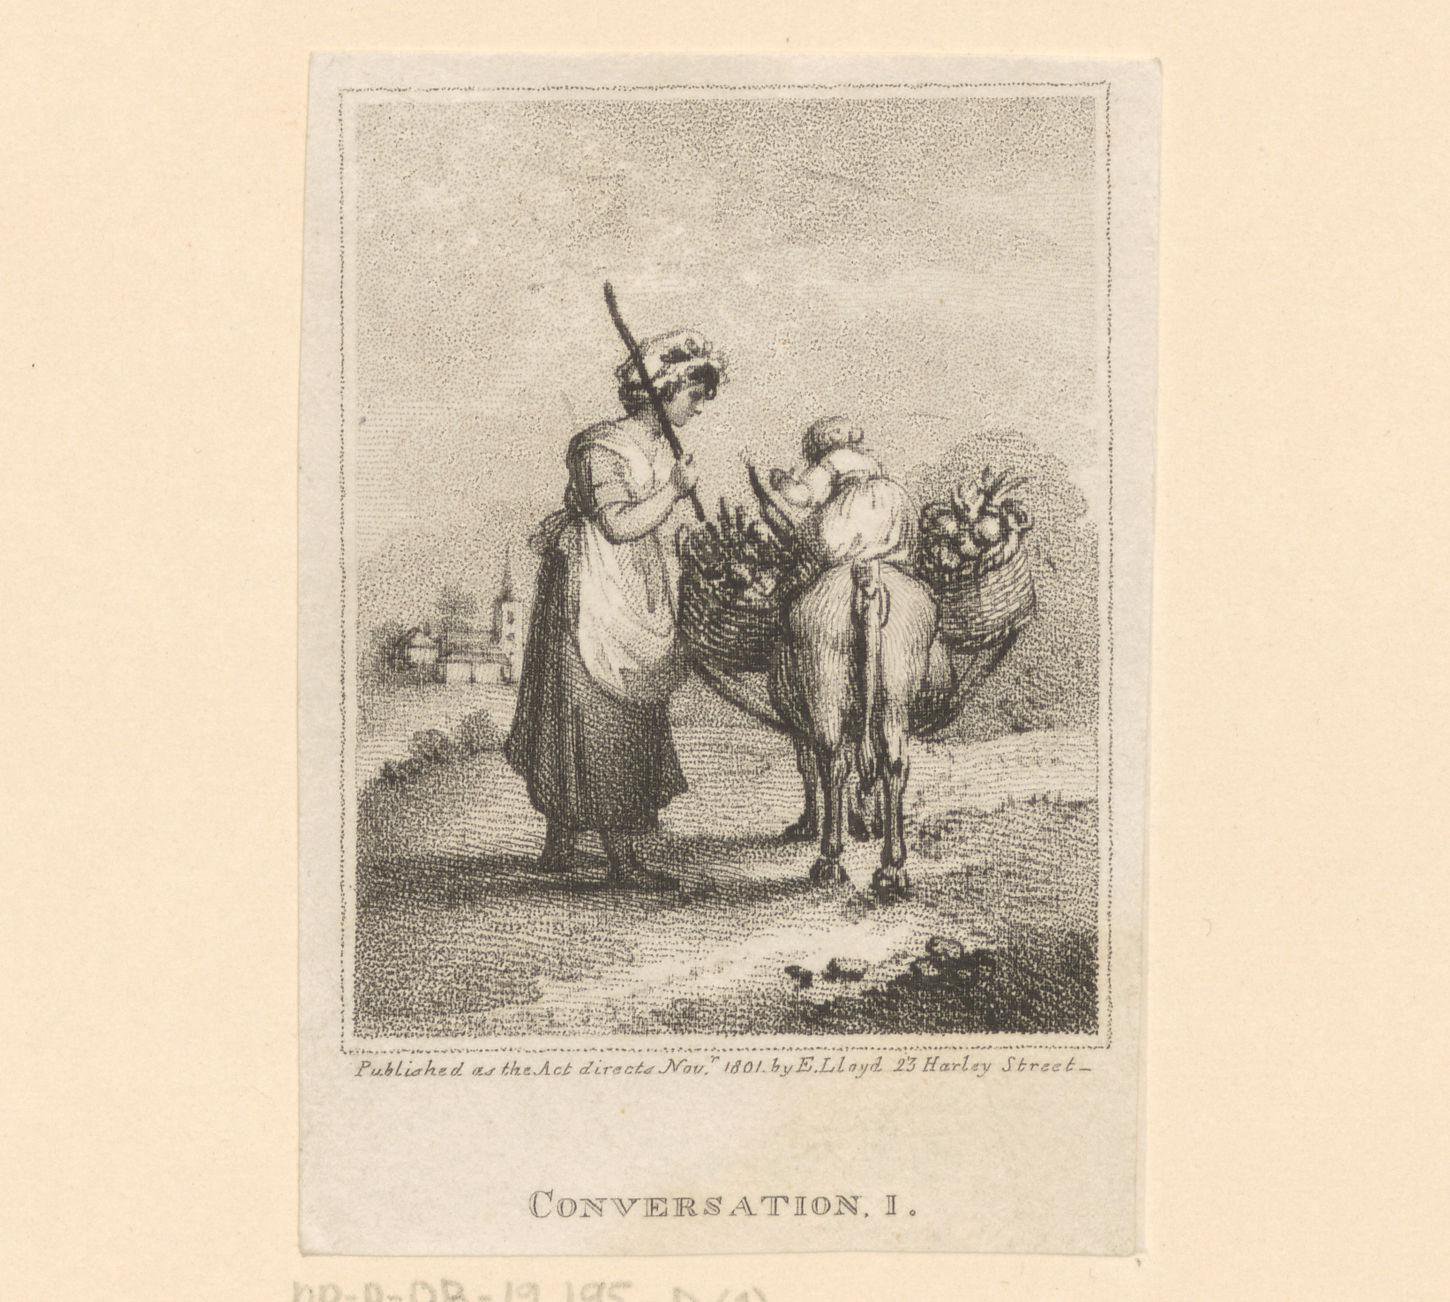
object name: print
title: Conversation I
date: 1801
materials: paper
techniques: etching, soft ground etching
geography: london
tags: horses and kindred animals, mother and baby or young child, 'en route', traveller under way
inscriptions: collector's mark: Lugt 2228